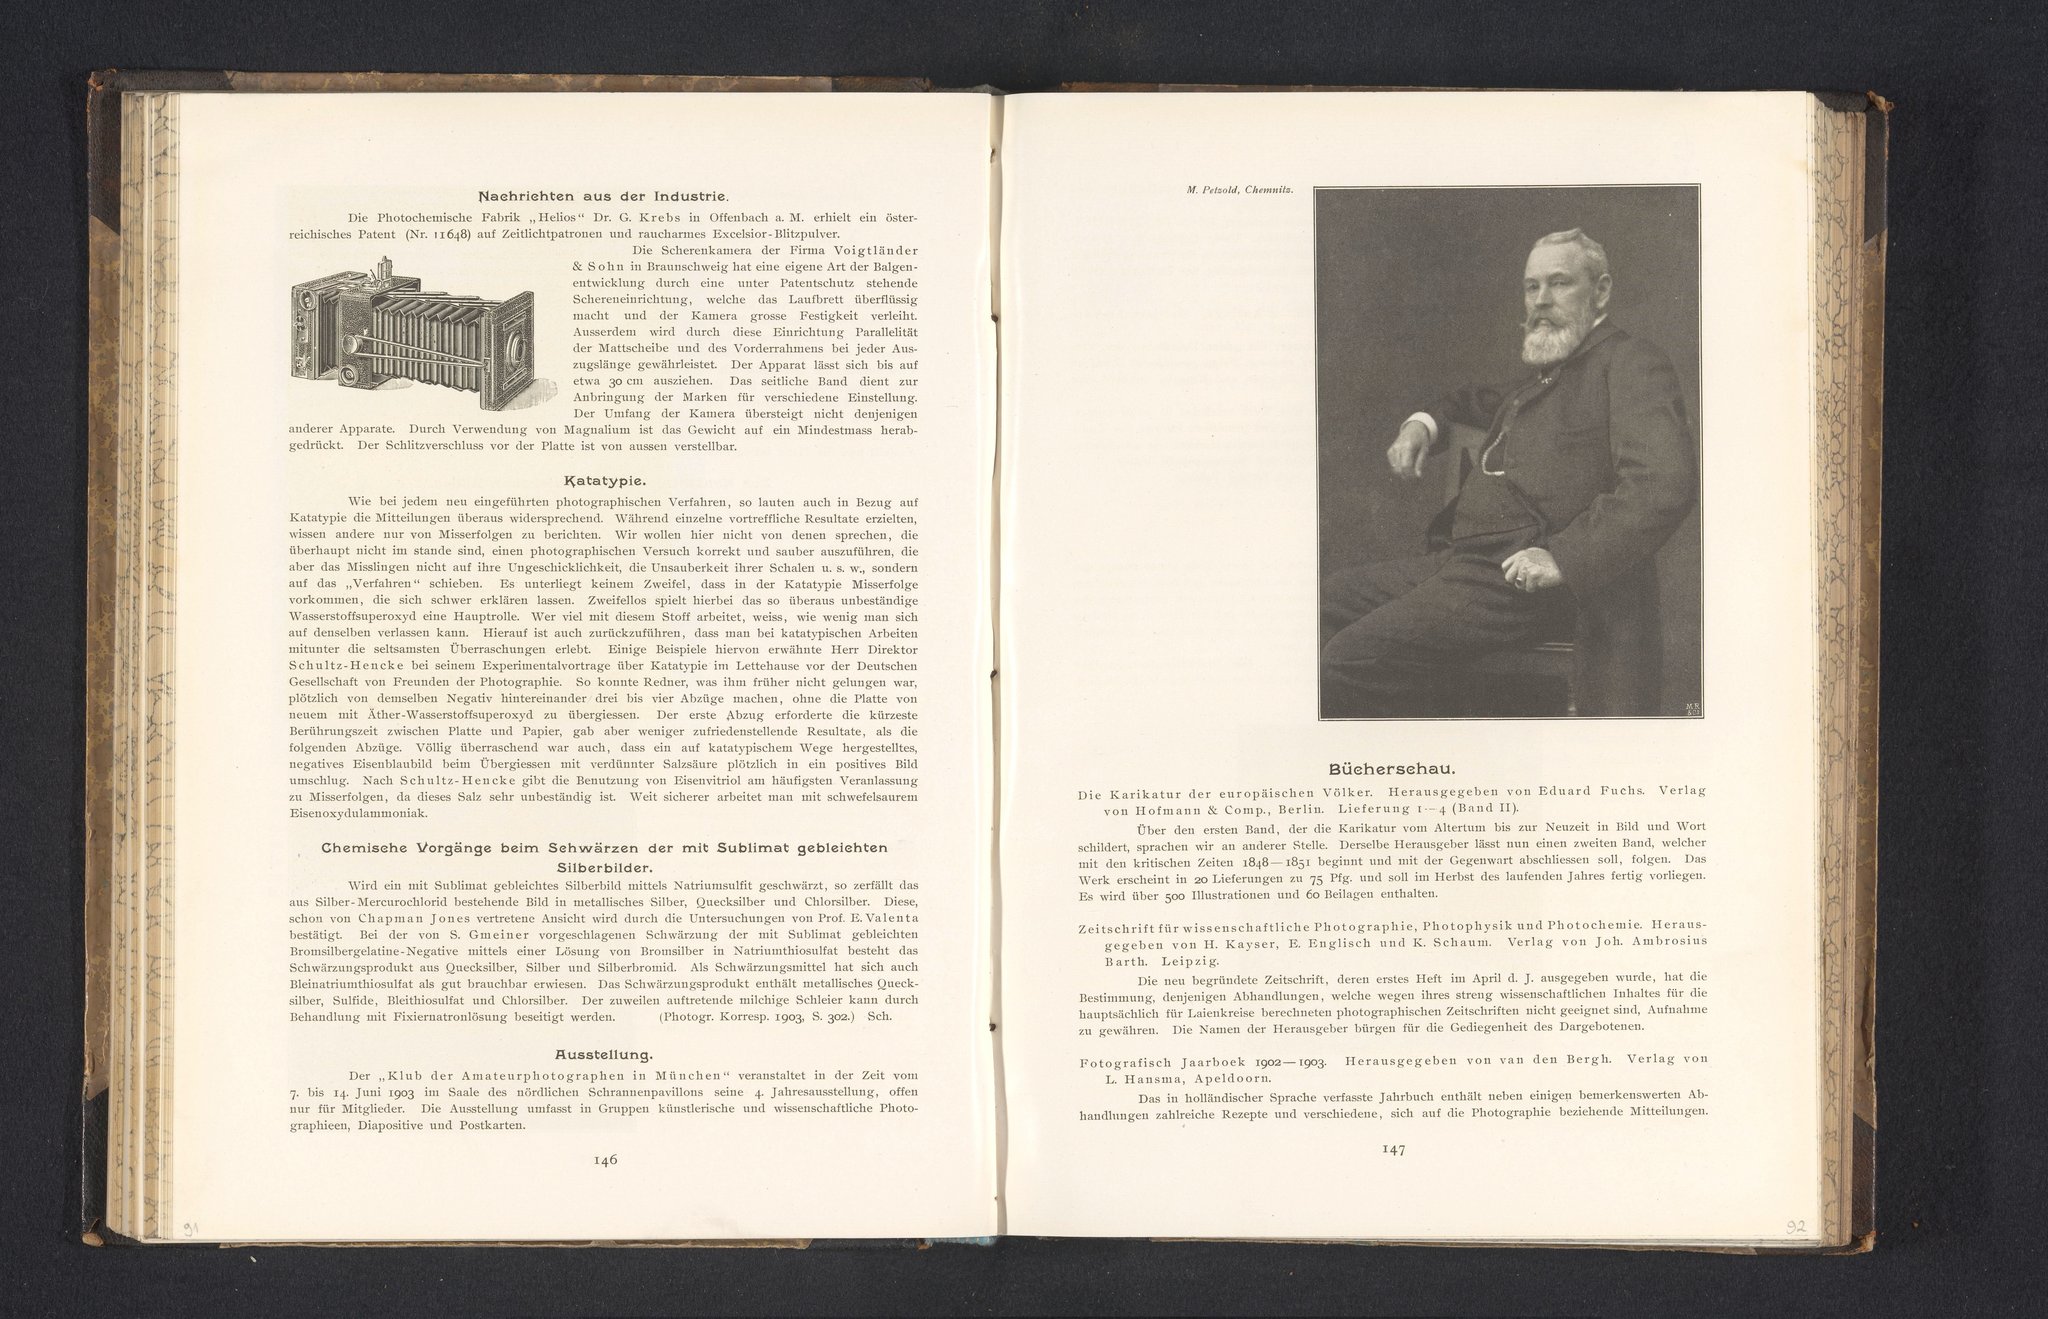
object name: page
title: Portret van een onbekende man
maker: m. petzold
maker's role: fotograaf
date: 1898-1903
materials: paper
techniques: autotype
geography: berlin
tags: historical persons not known by name